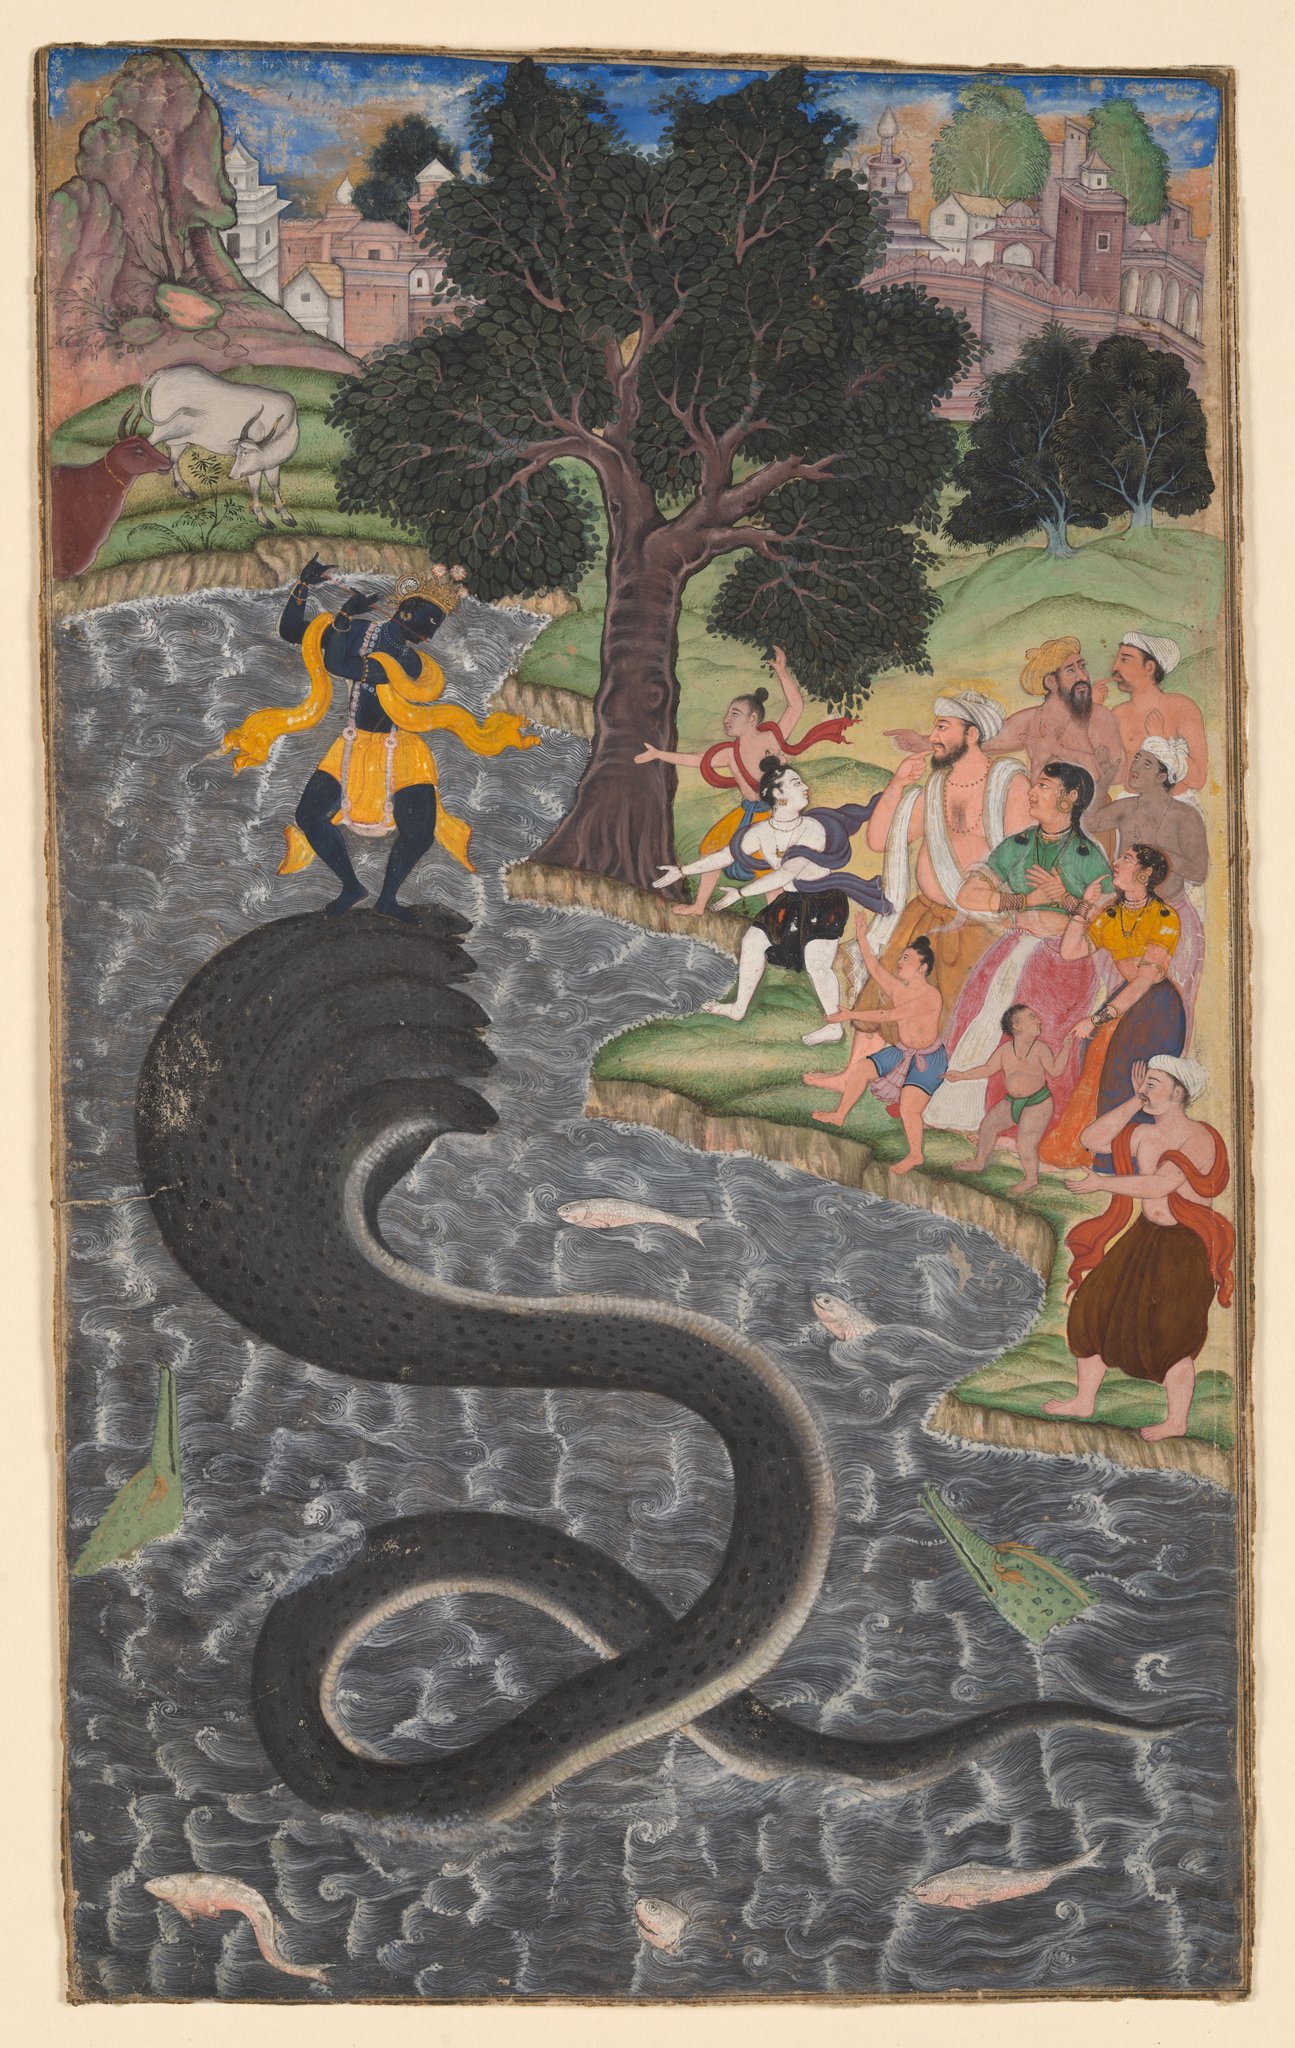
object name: folio from an illustrated manuscript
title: Krishna Dances on the Head of Kaliya; Illustration to the Harivamsa (Story of Hari)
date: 1590-1595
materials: gold, paper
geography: india